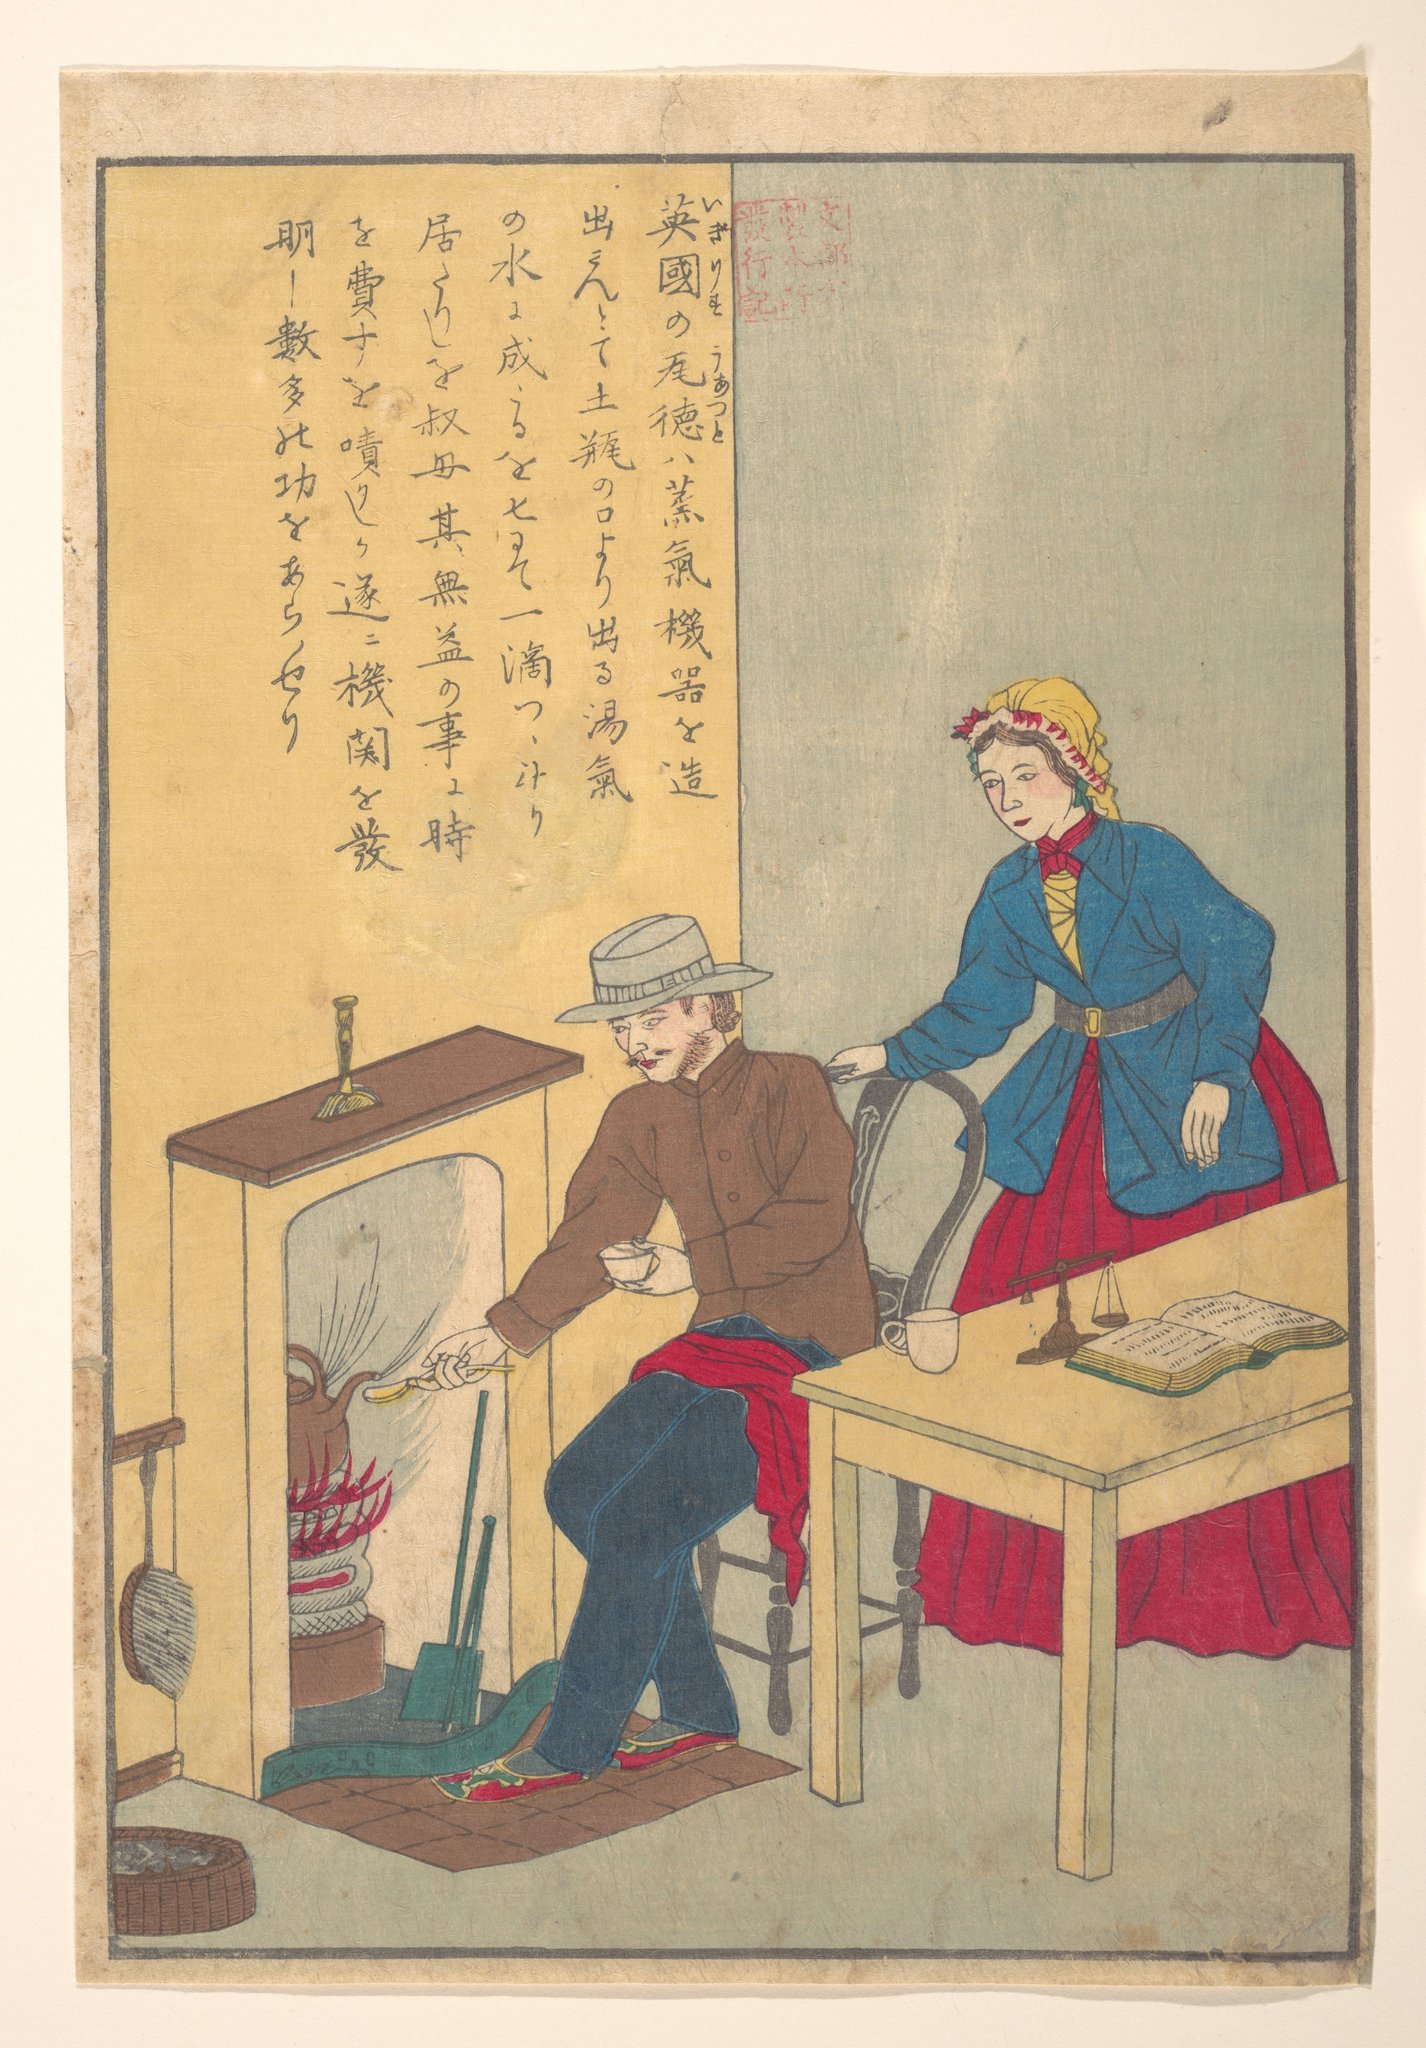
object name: print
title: Lives of Great People of the Occident (Taisei ijin den): James Watt (1736–1819)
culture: japanese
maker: unidentified artist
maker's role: artist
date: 1870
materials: ink, paper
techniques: woodblock print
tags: men,women,scales,kettles